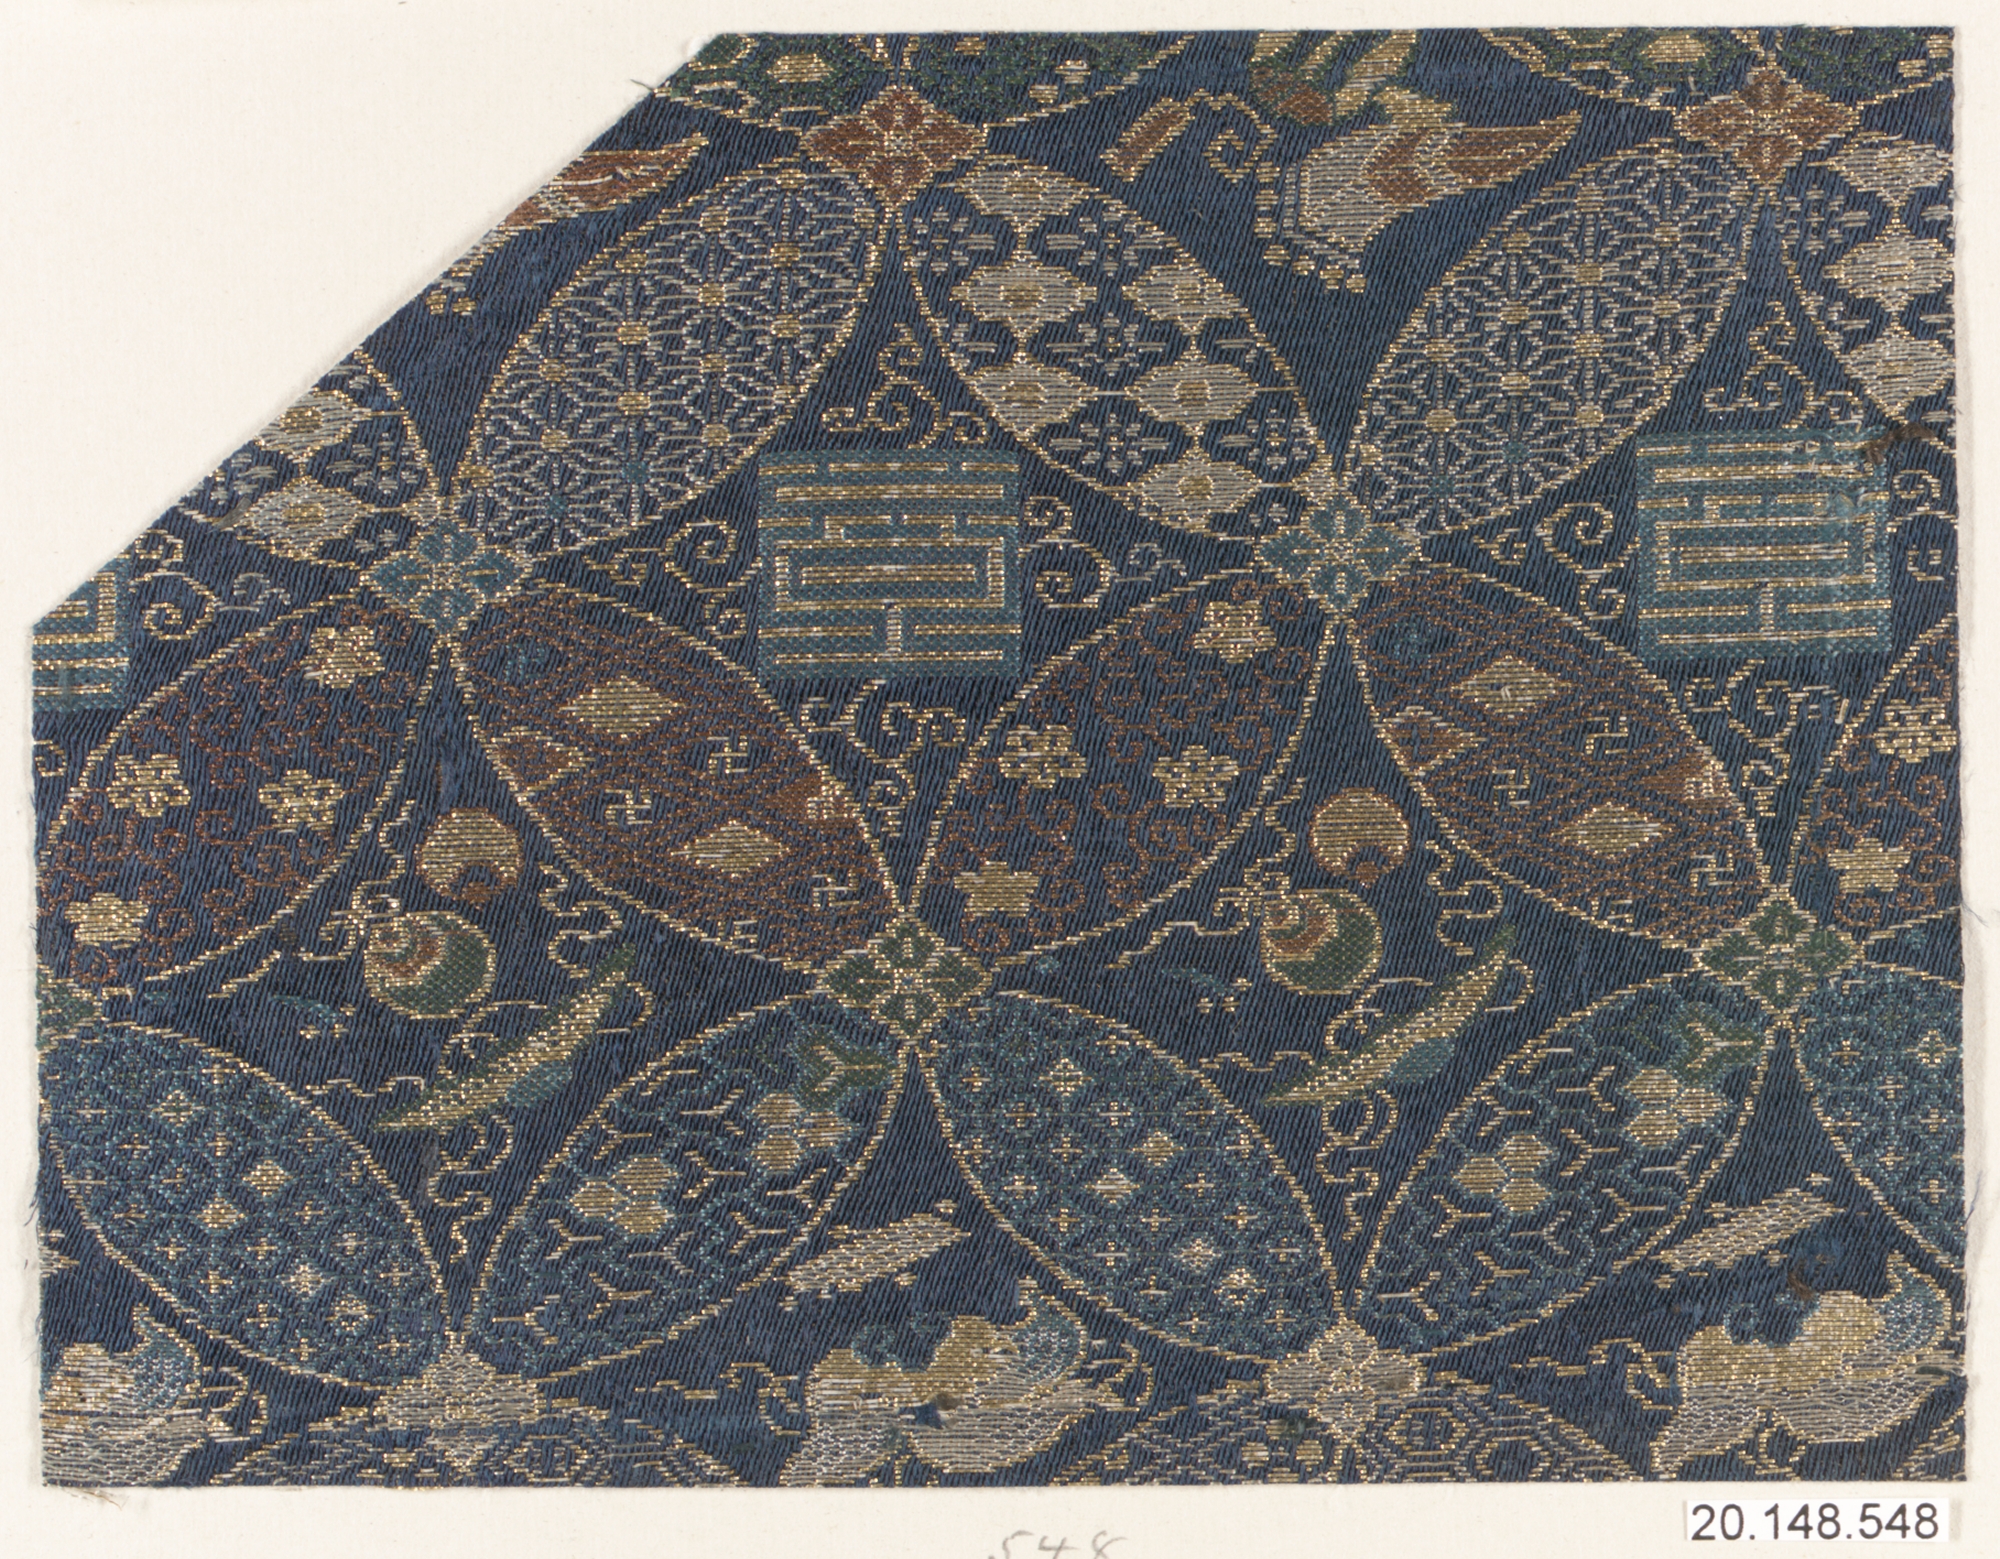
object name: piece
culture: chinese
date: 1701-1800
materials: silk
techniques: compound weave